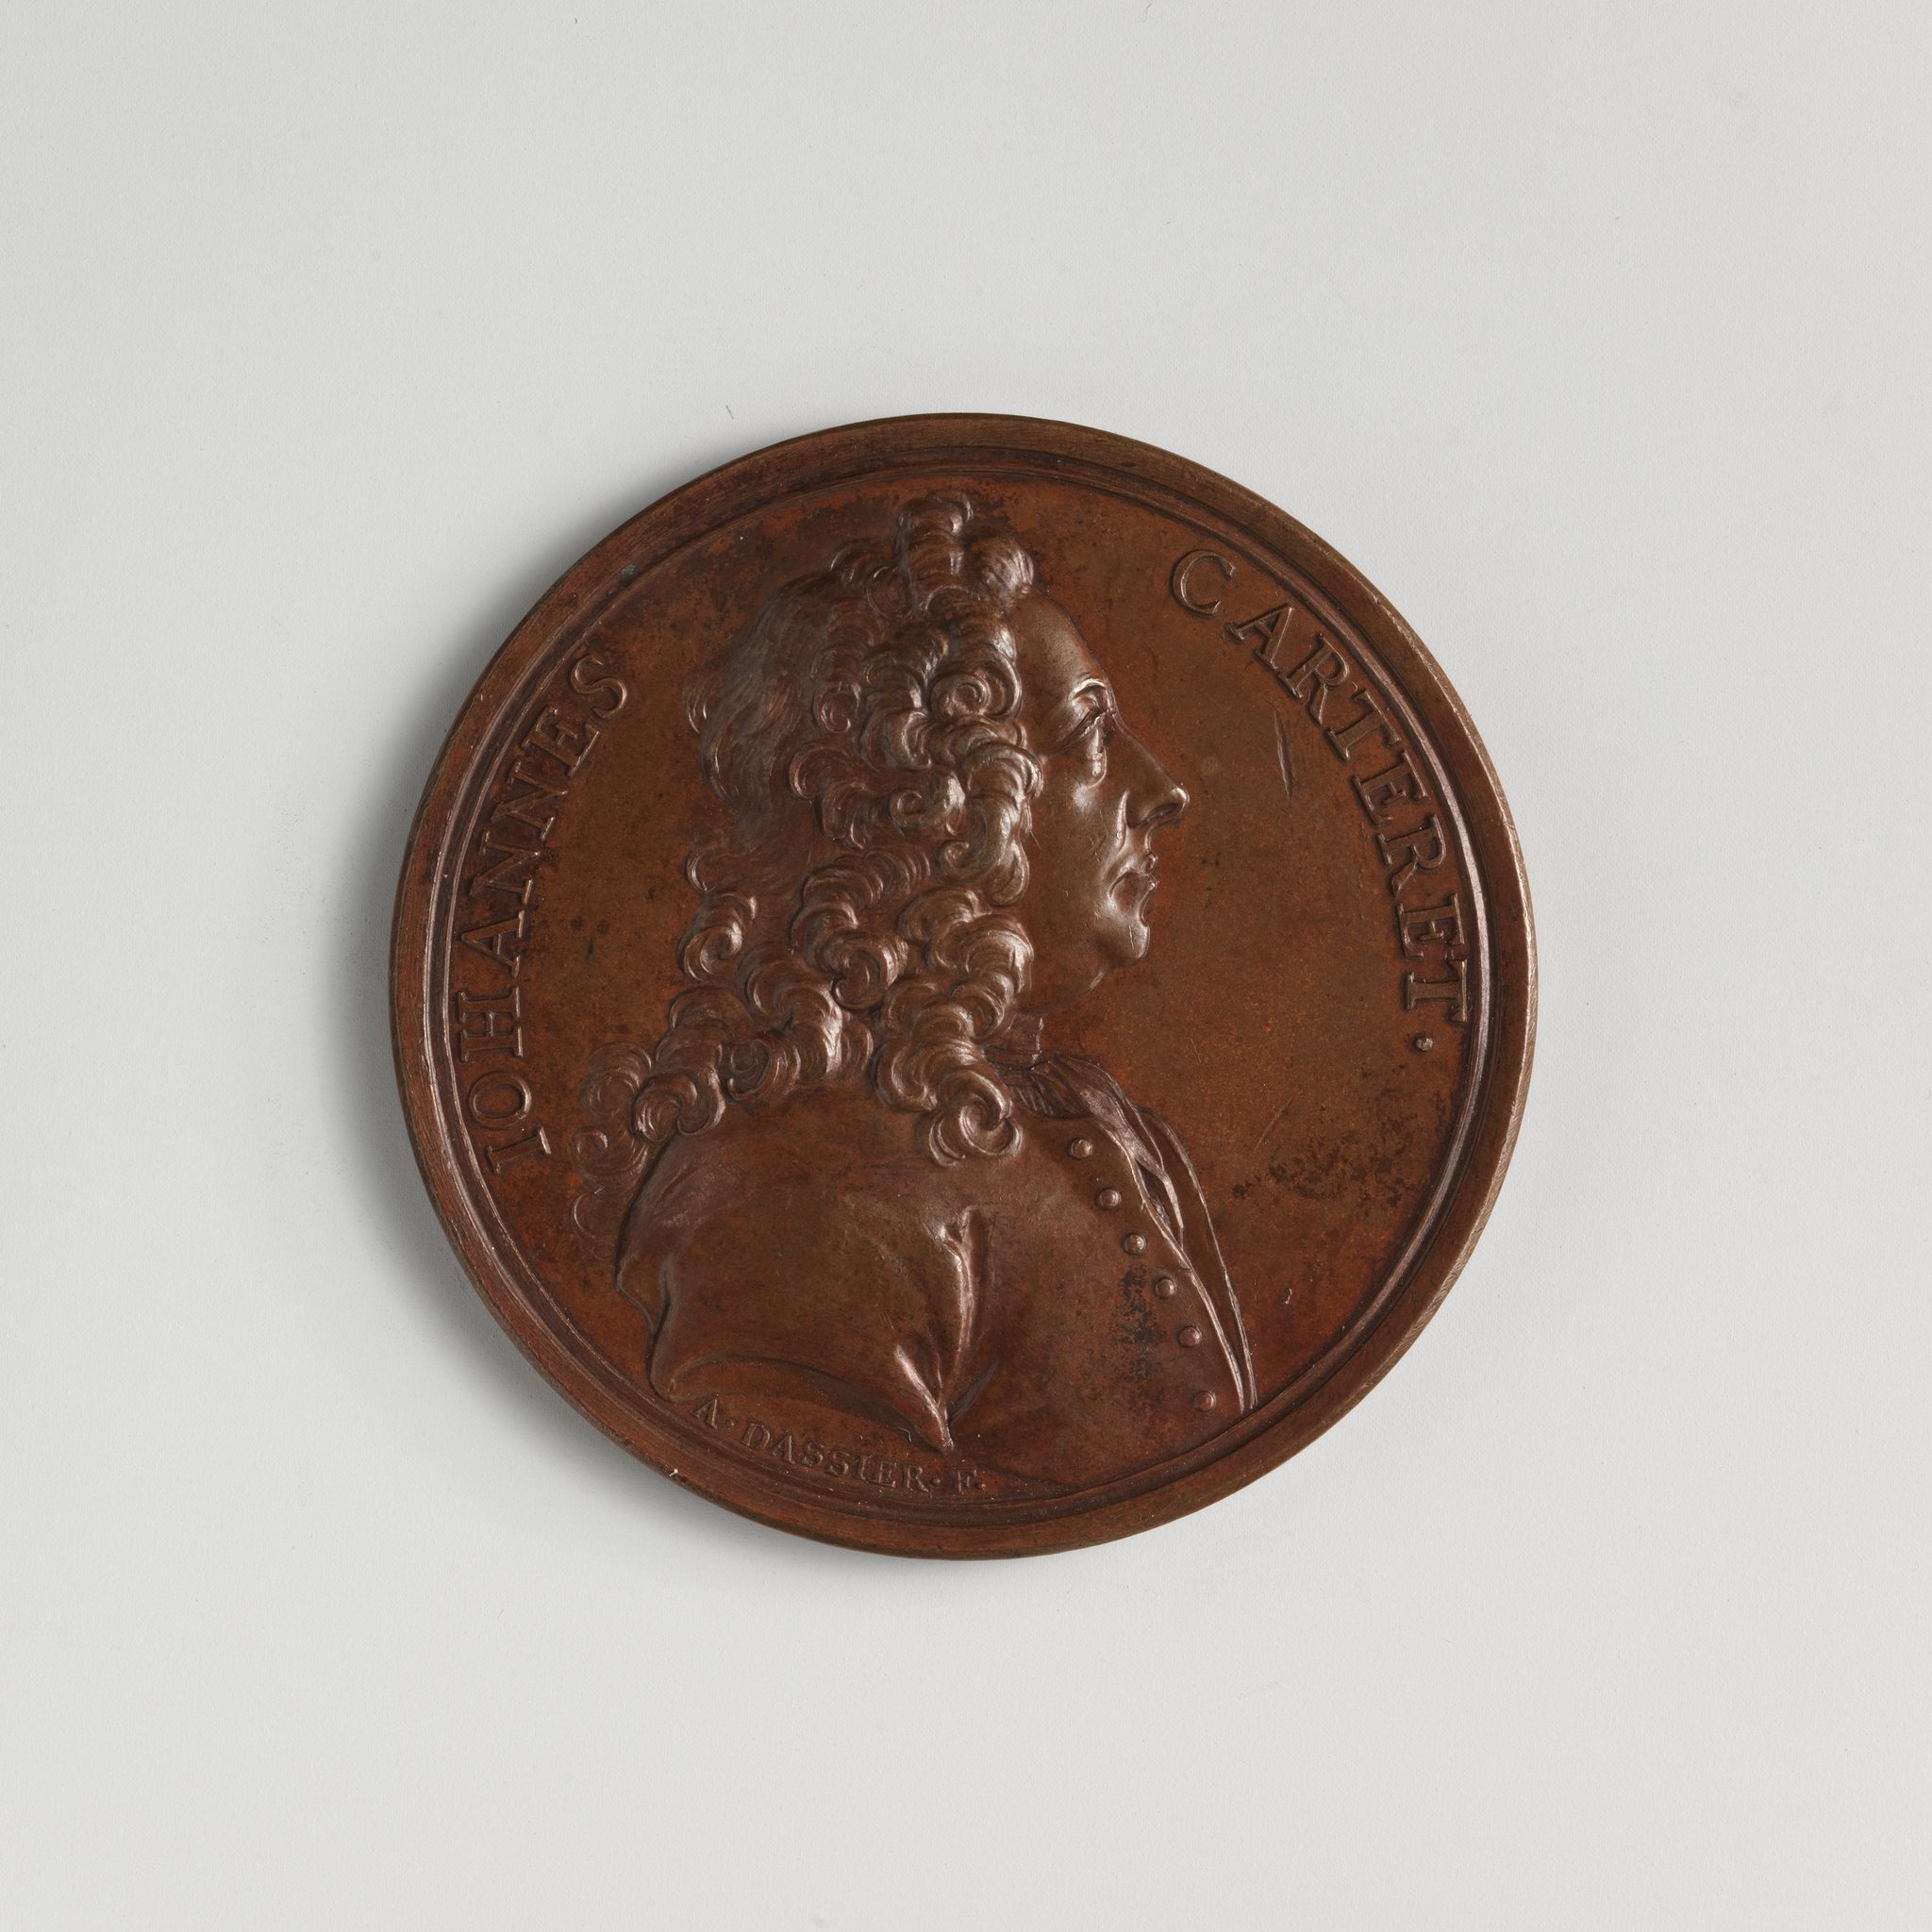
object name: medal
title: John Carteret, 2nd Earl of Granville (1690–1763)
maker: jacques-antoine dassier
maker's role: artist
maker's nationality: swiss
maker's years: 1715-1759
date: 1744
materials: bronze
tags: men,profiles